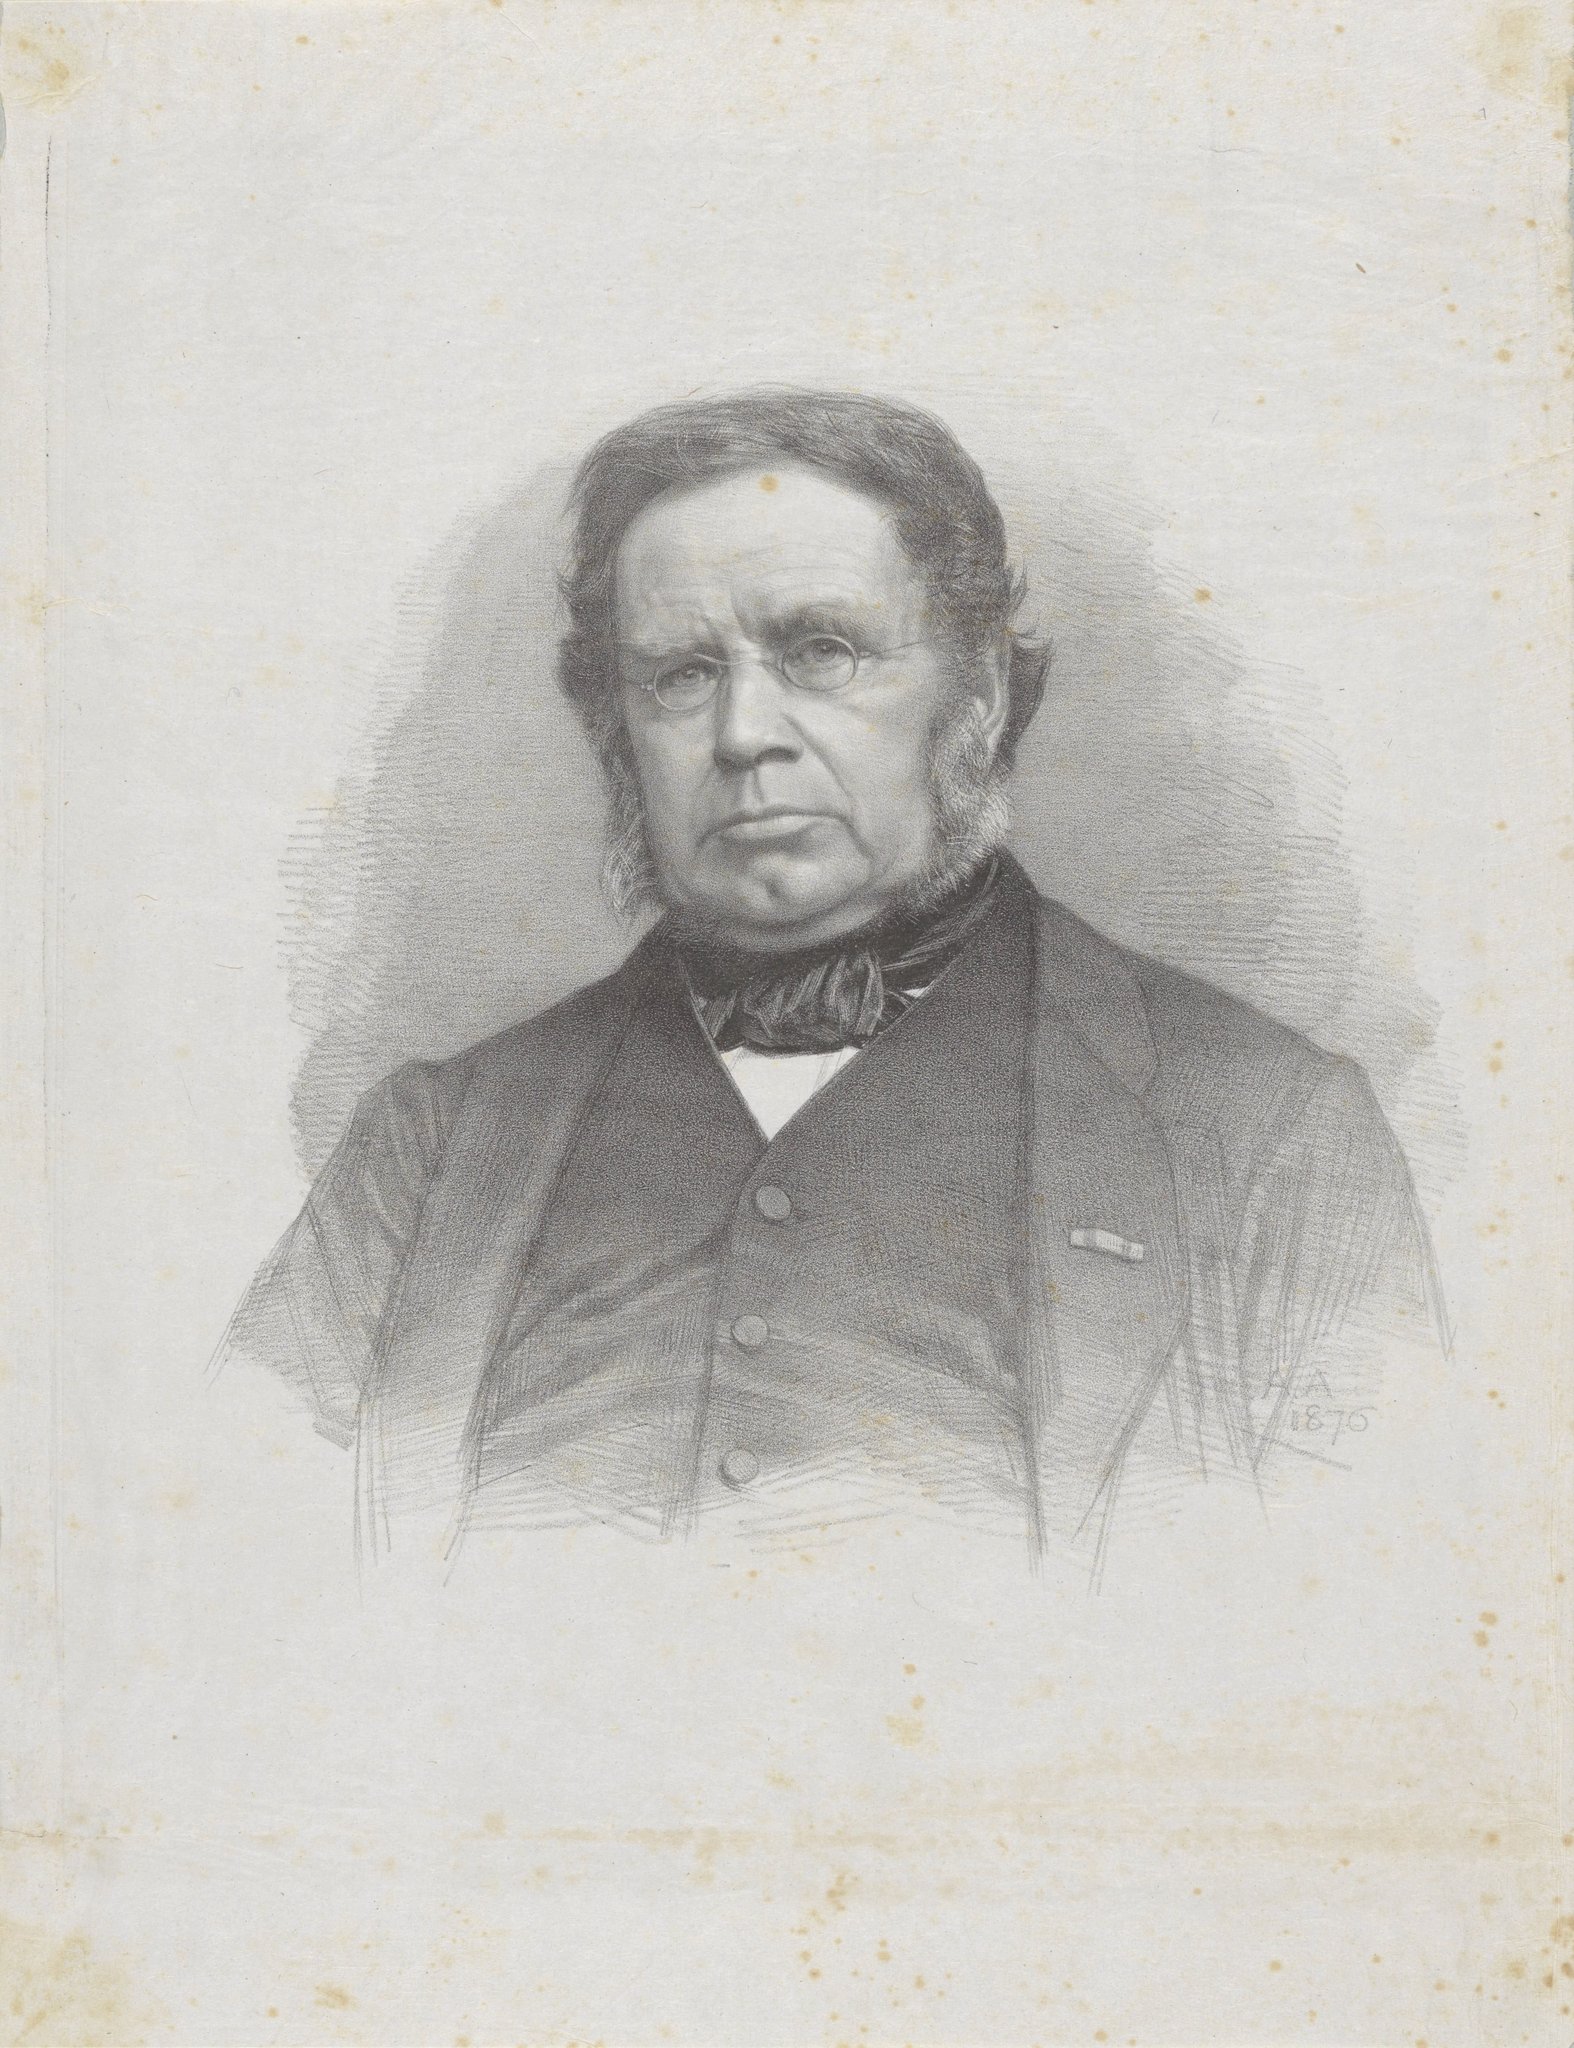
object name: print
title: Portret van dominee Ottho Gerhard Heldring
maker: august allebé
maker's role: draughtsman, print maker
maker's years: 1838-1927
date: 1876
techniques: lithography, printmaking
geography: amsterdam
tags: marienbad, historical persons, functionaries and dignitaries ~ protestant churches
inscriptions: collector's mark: Lugt 2228